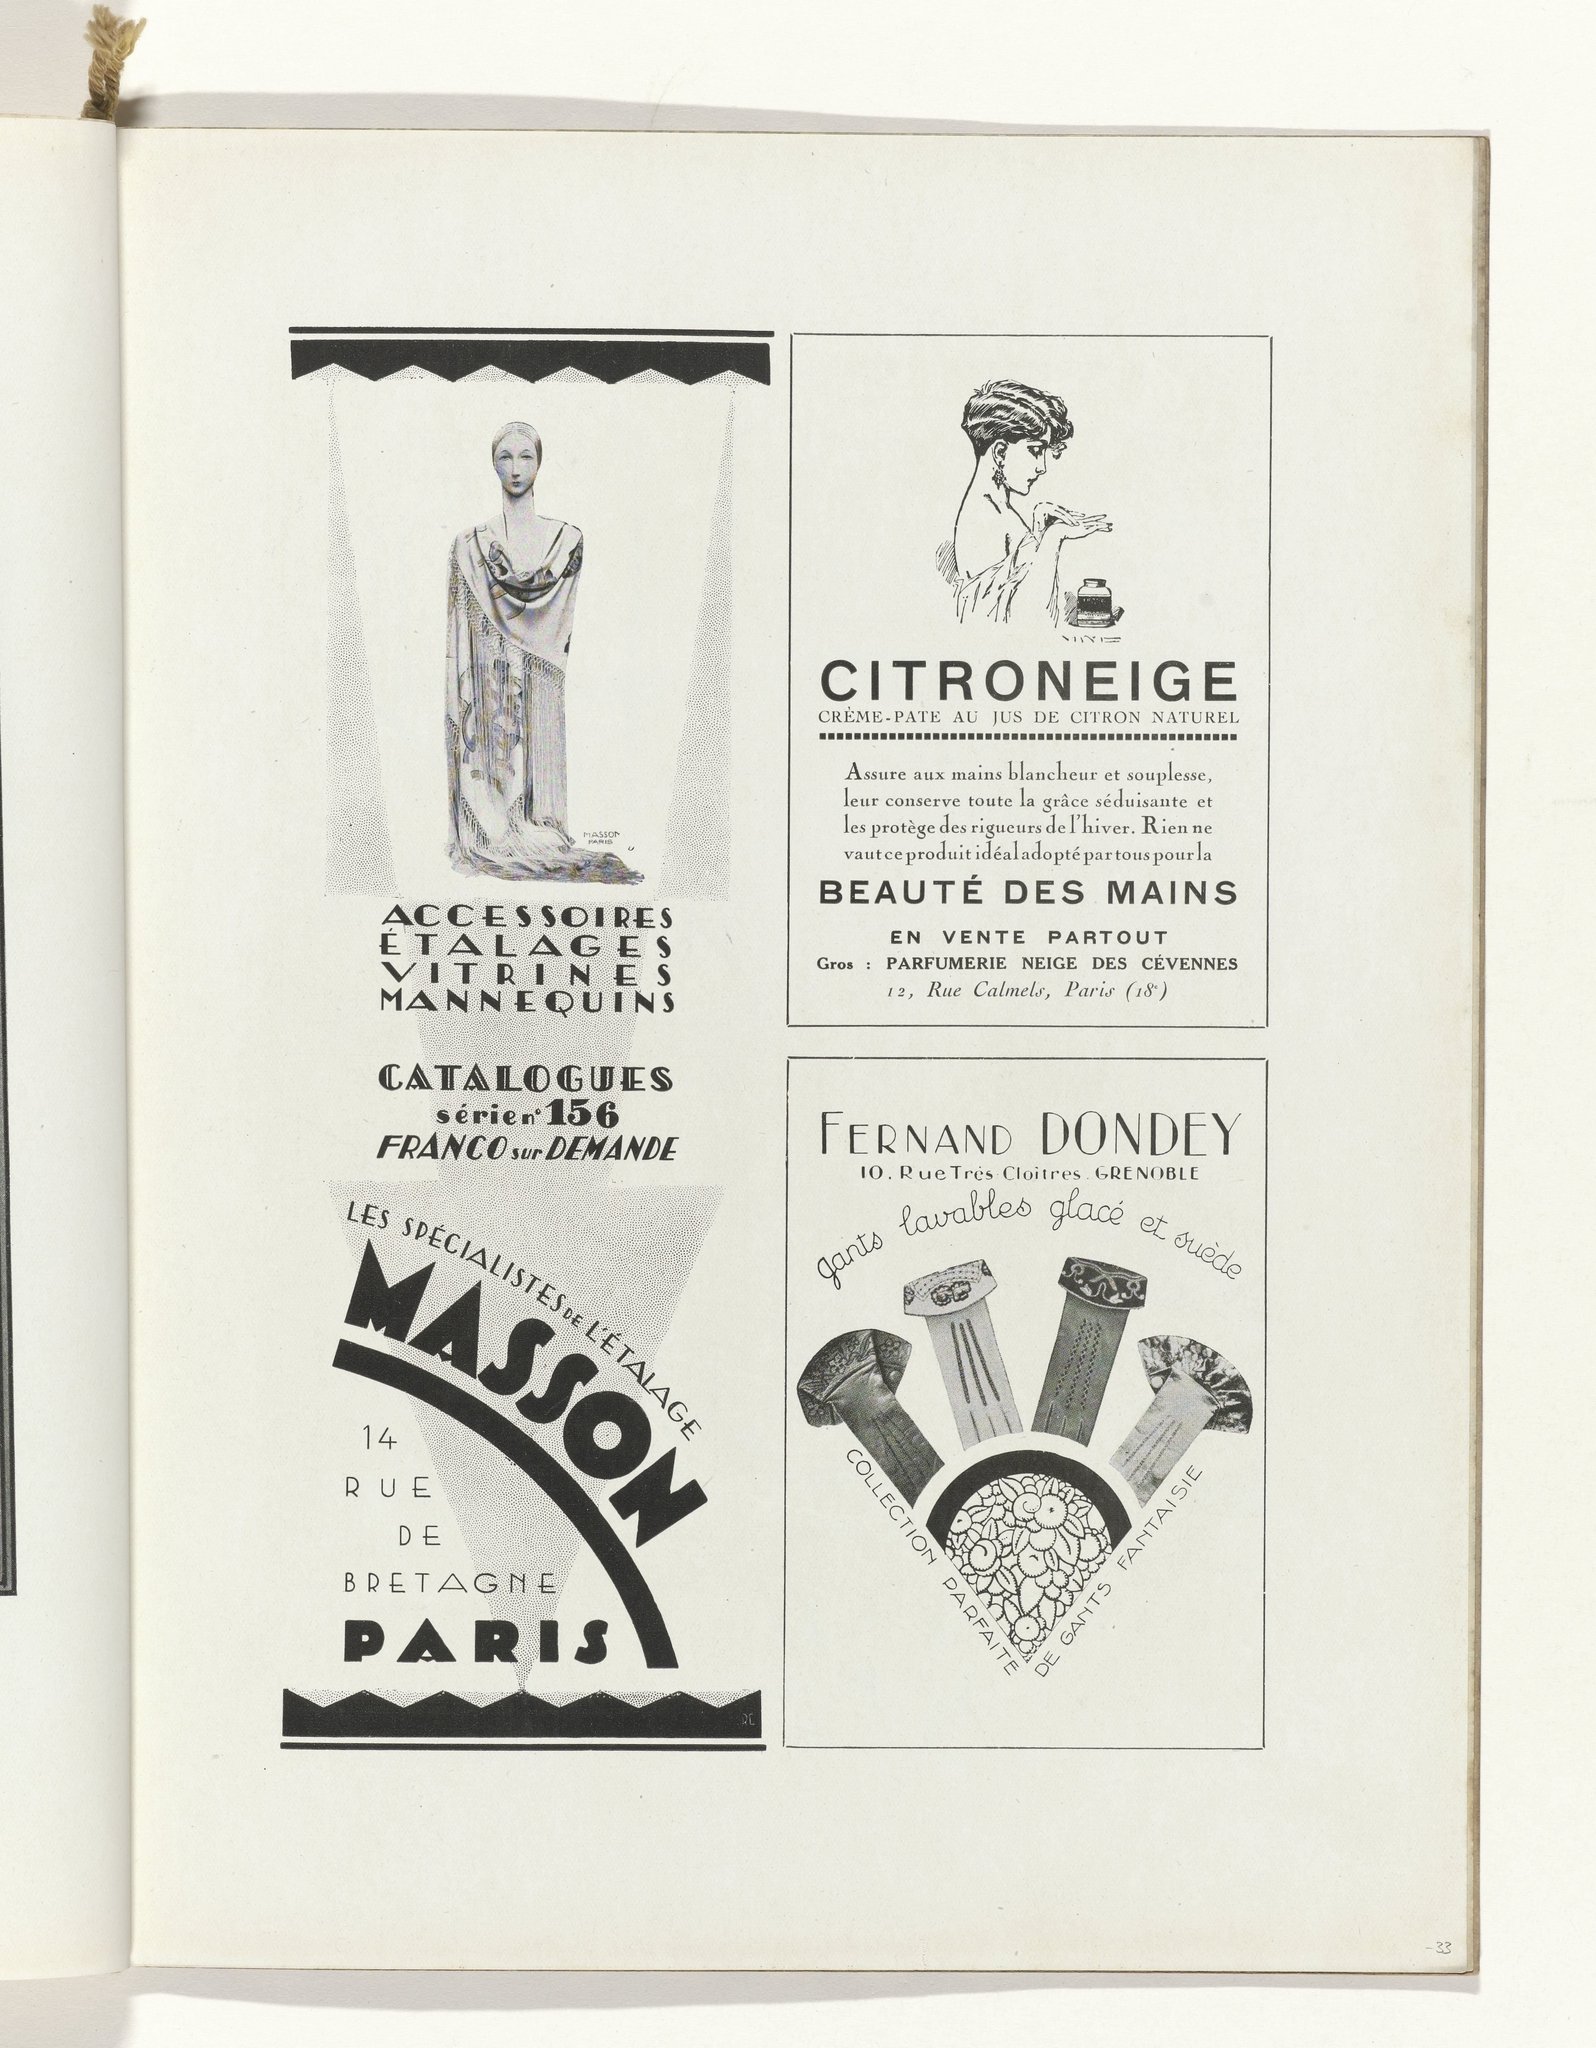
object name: fashion print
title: Art - Goût - Beauté, Feuillets de l' élégance féminine, Mars 1929, No. 103, 9e Année, p. 33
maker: charles goy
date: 1929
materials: paper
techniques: photography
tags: clothing for the upper part of the body (shawl) (+ women's clothes), gloves, mittens (short gloves) (+ women's clothes), shop-window figures, fashion plates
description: Drie advertenties voor onder andere etalagemateriaal en handschoenen. Pagina uit het modetijdschrift Art-Goût-Beauté (1920-1933).